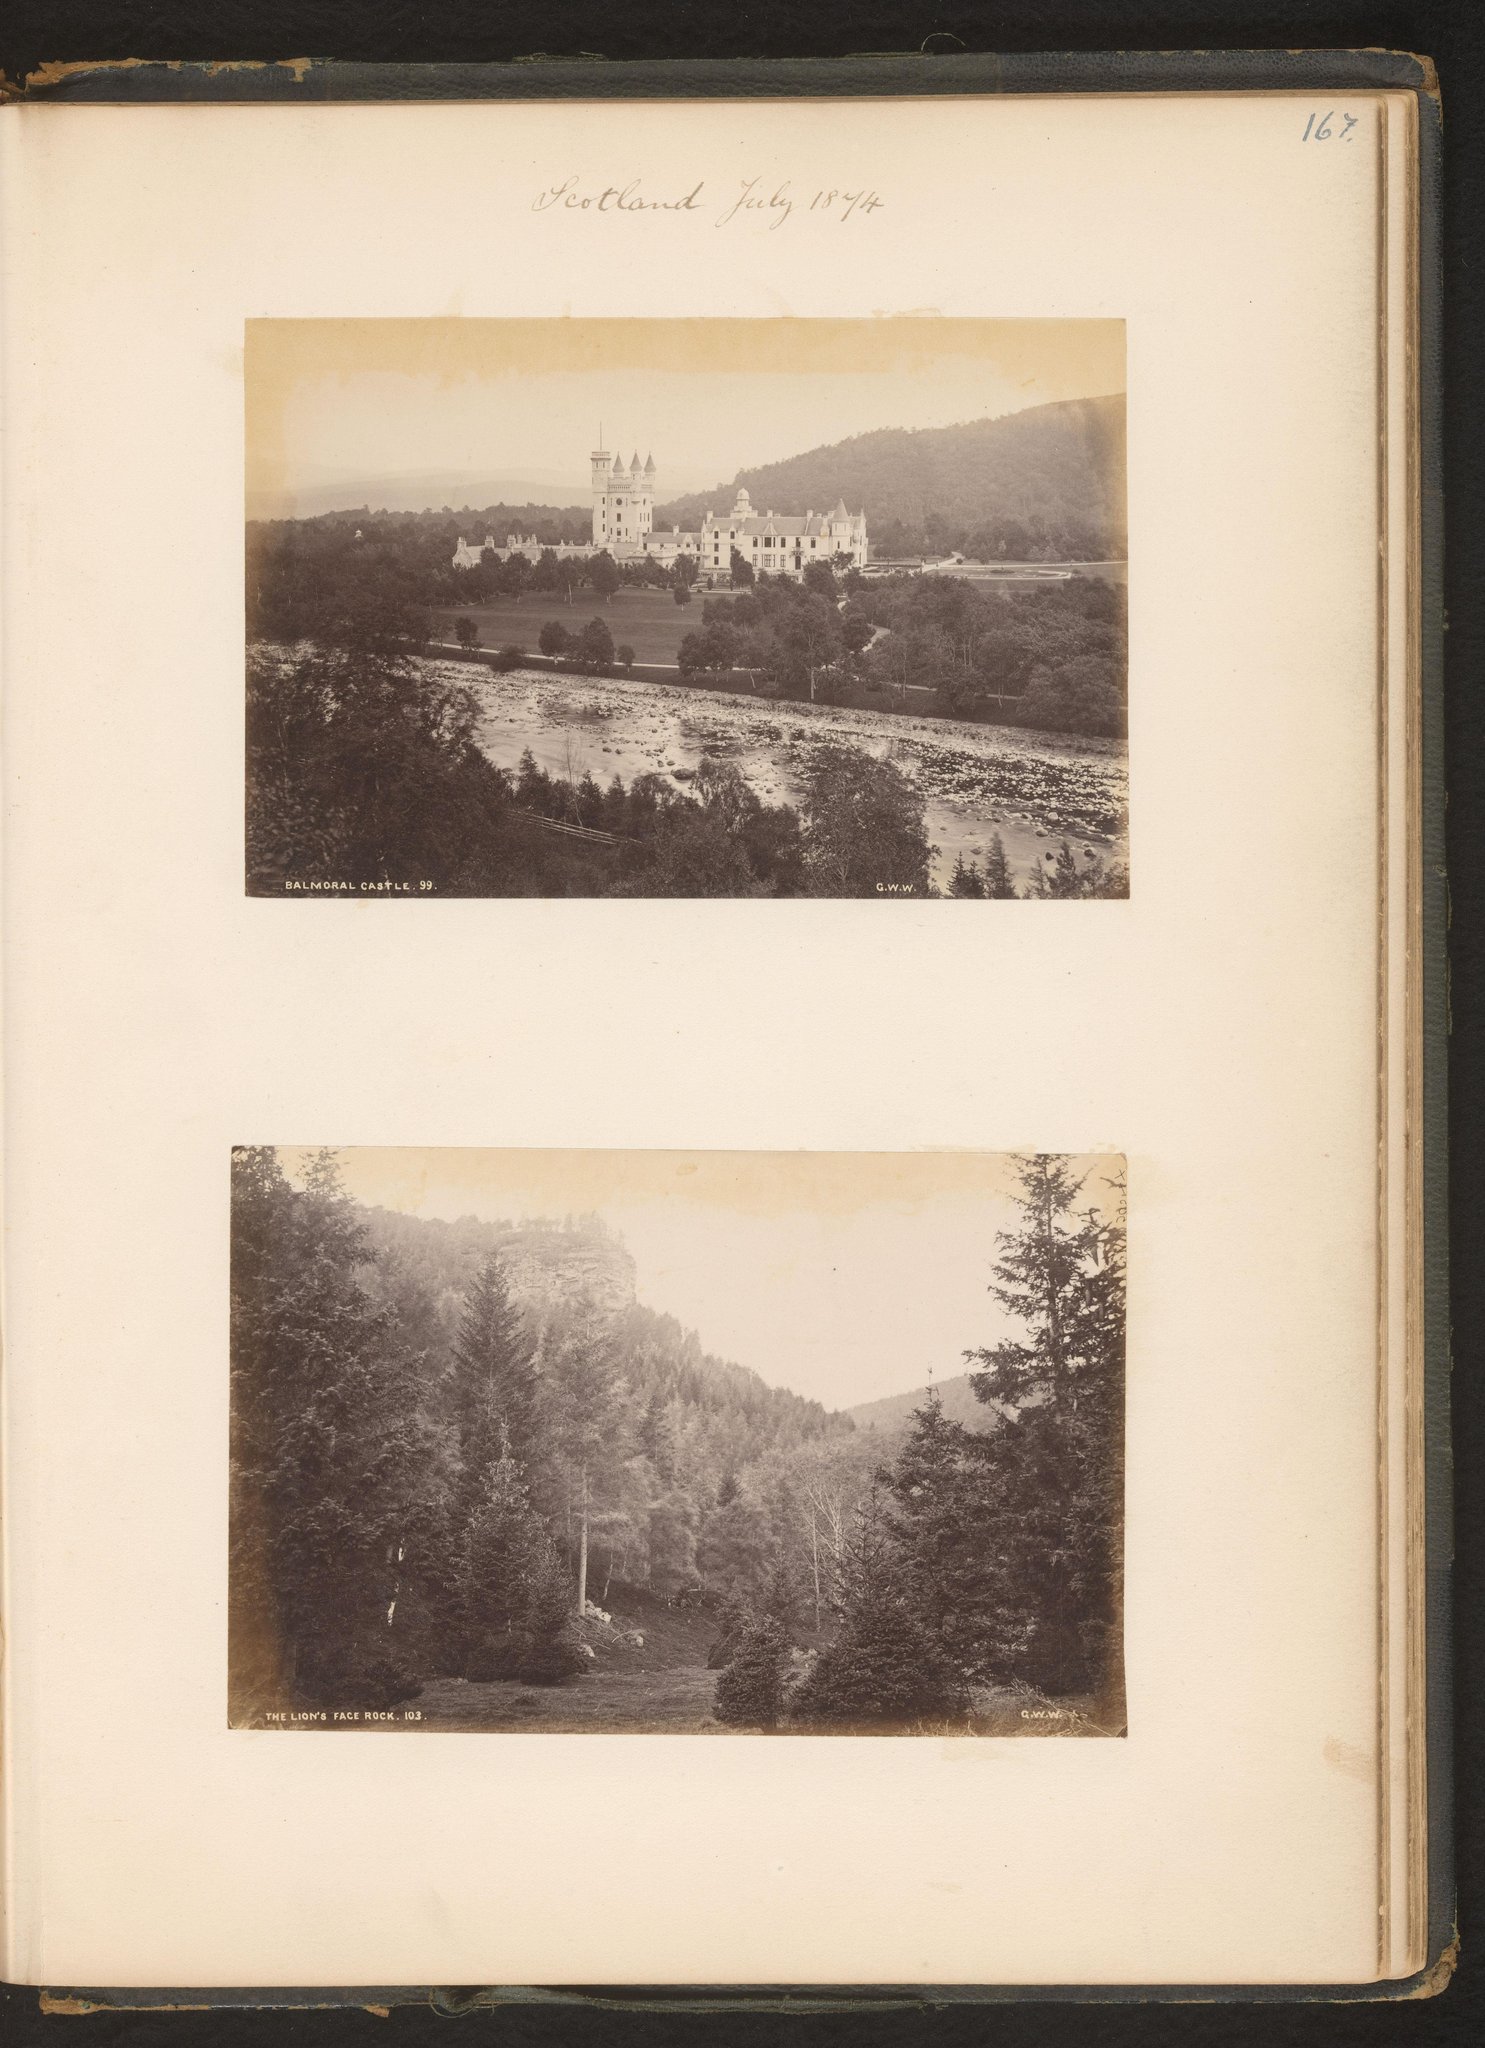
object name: album leaf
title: Gezicht op Balmoral Castle bij Ballater en gezicht op the lion's face rock bij Braemar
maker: Anonymous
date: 1807-1874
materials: paper, photographic support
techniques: albumen print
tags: castle, forest, wood, rocks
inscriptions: inscription: ‘The Lion's Face Rock, 103. G.W.W.’, inscription: ‘Balmoral Castle 99 G.W.W.’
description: Deze pagina maakt deel uit van een album.